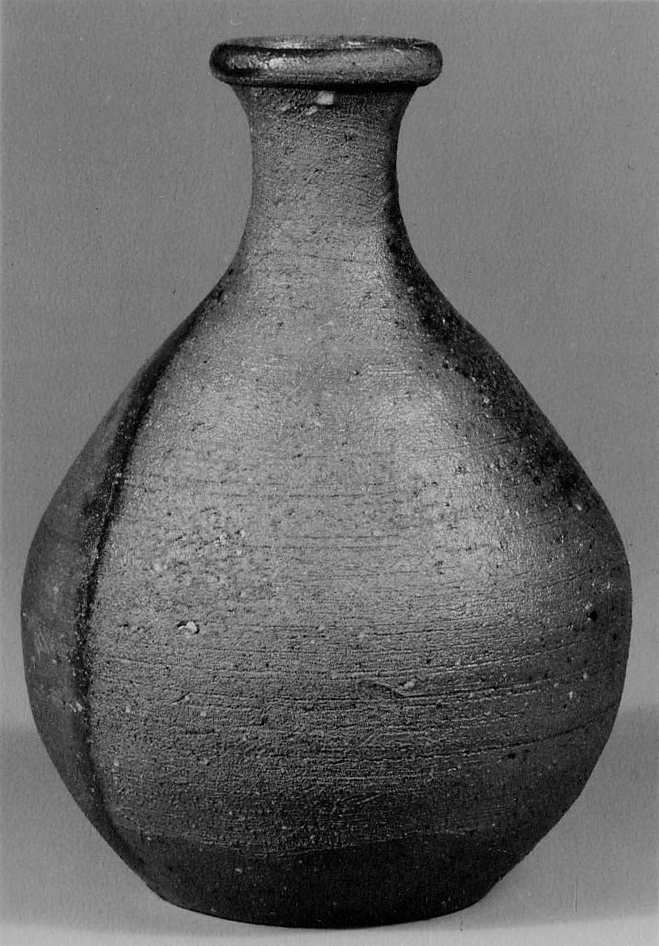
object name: sake bottle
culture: japanese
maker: yu fujiwara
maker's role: artist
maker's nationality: japanese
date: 1934-1966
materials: earthenware, glaze